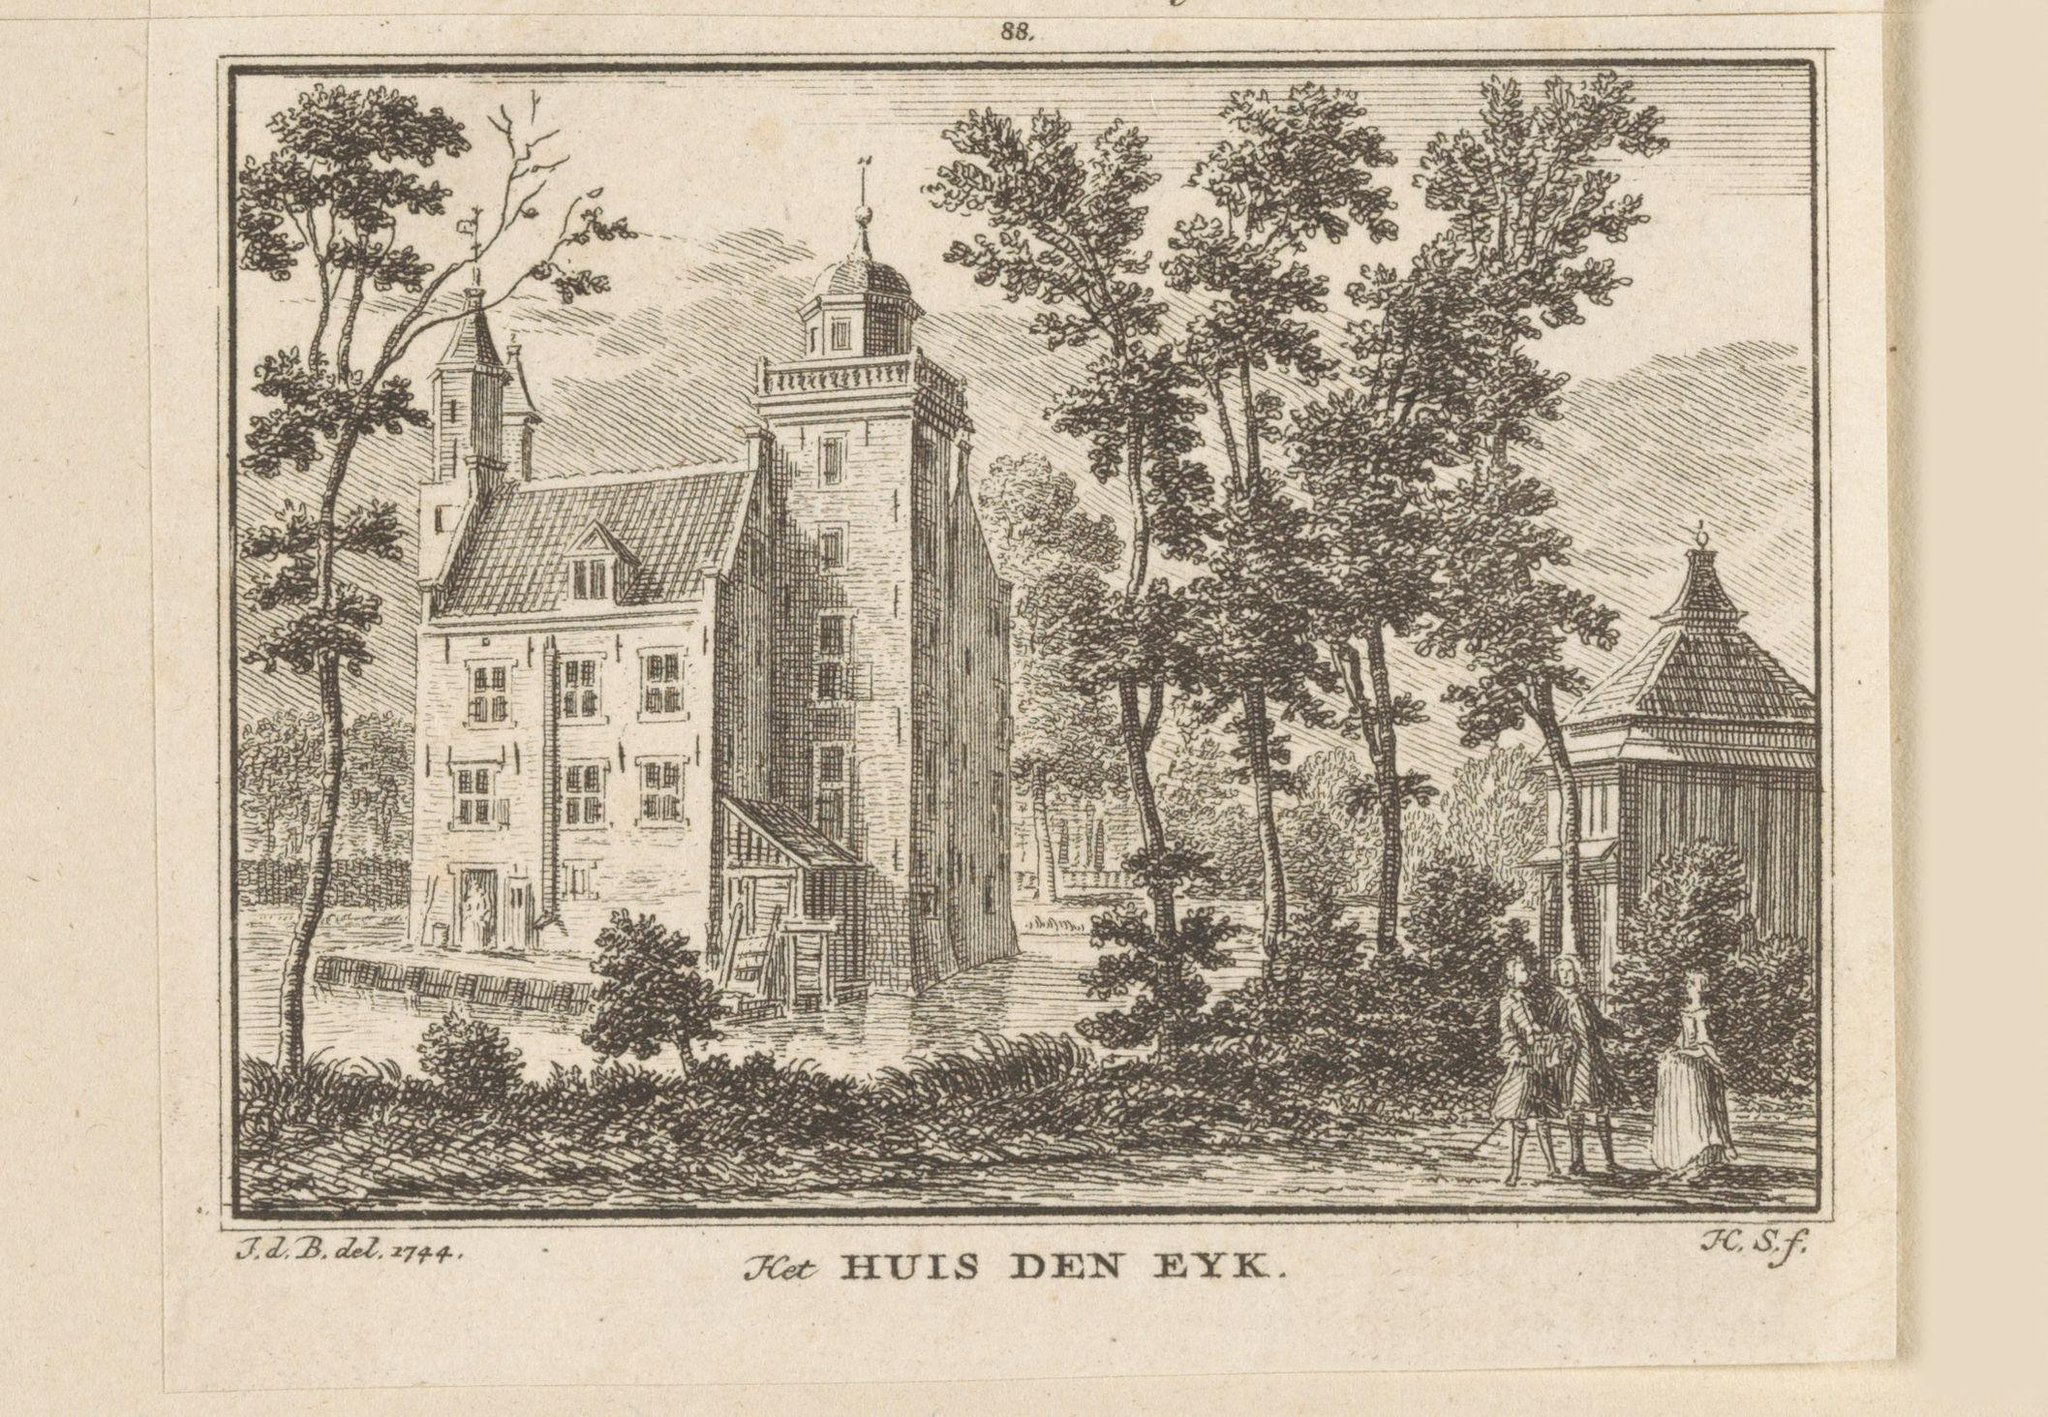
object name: print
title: Het huis Den Eyk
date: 1773-1792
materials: paper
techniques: engraving, etching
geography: haarlem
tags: castle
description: Prent ook gebruikt in: Het verheerlykt Nederland of kabinet van hedendaagsche gezigten van steden, dorpen (…). 9 delen. Amsterdam: Isaak Tirion en weduwe Isaak Tirion, 1745-1774, dl. 7, 8 of 9 (weduwe Isaak Tirion, 1773-1774), ill. 88. Of in: Nederlandsche tafereelen; of eene keurige verzameling van negen honderd fraaije gezigten van steden, dorpen, sloten, oudheden (….). 9 delen. Amsterdam: Jan de Groot, 1792, dl. 7, 8 of 9, ill. 88. Uit welke druk het huidige exemplaar precies komt is niet na te gaan.